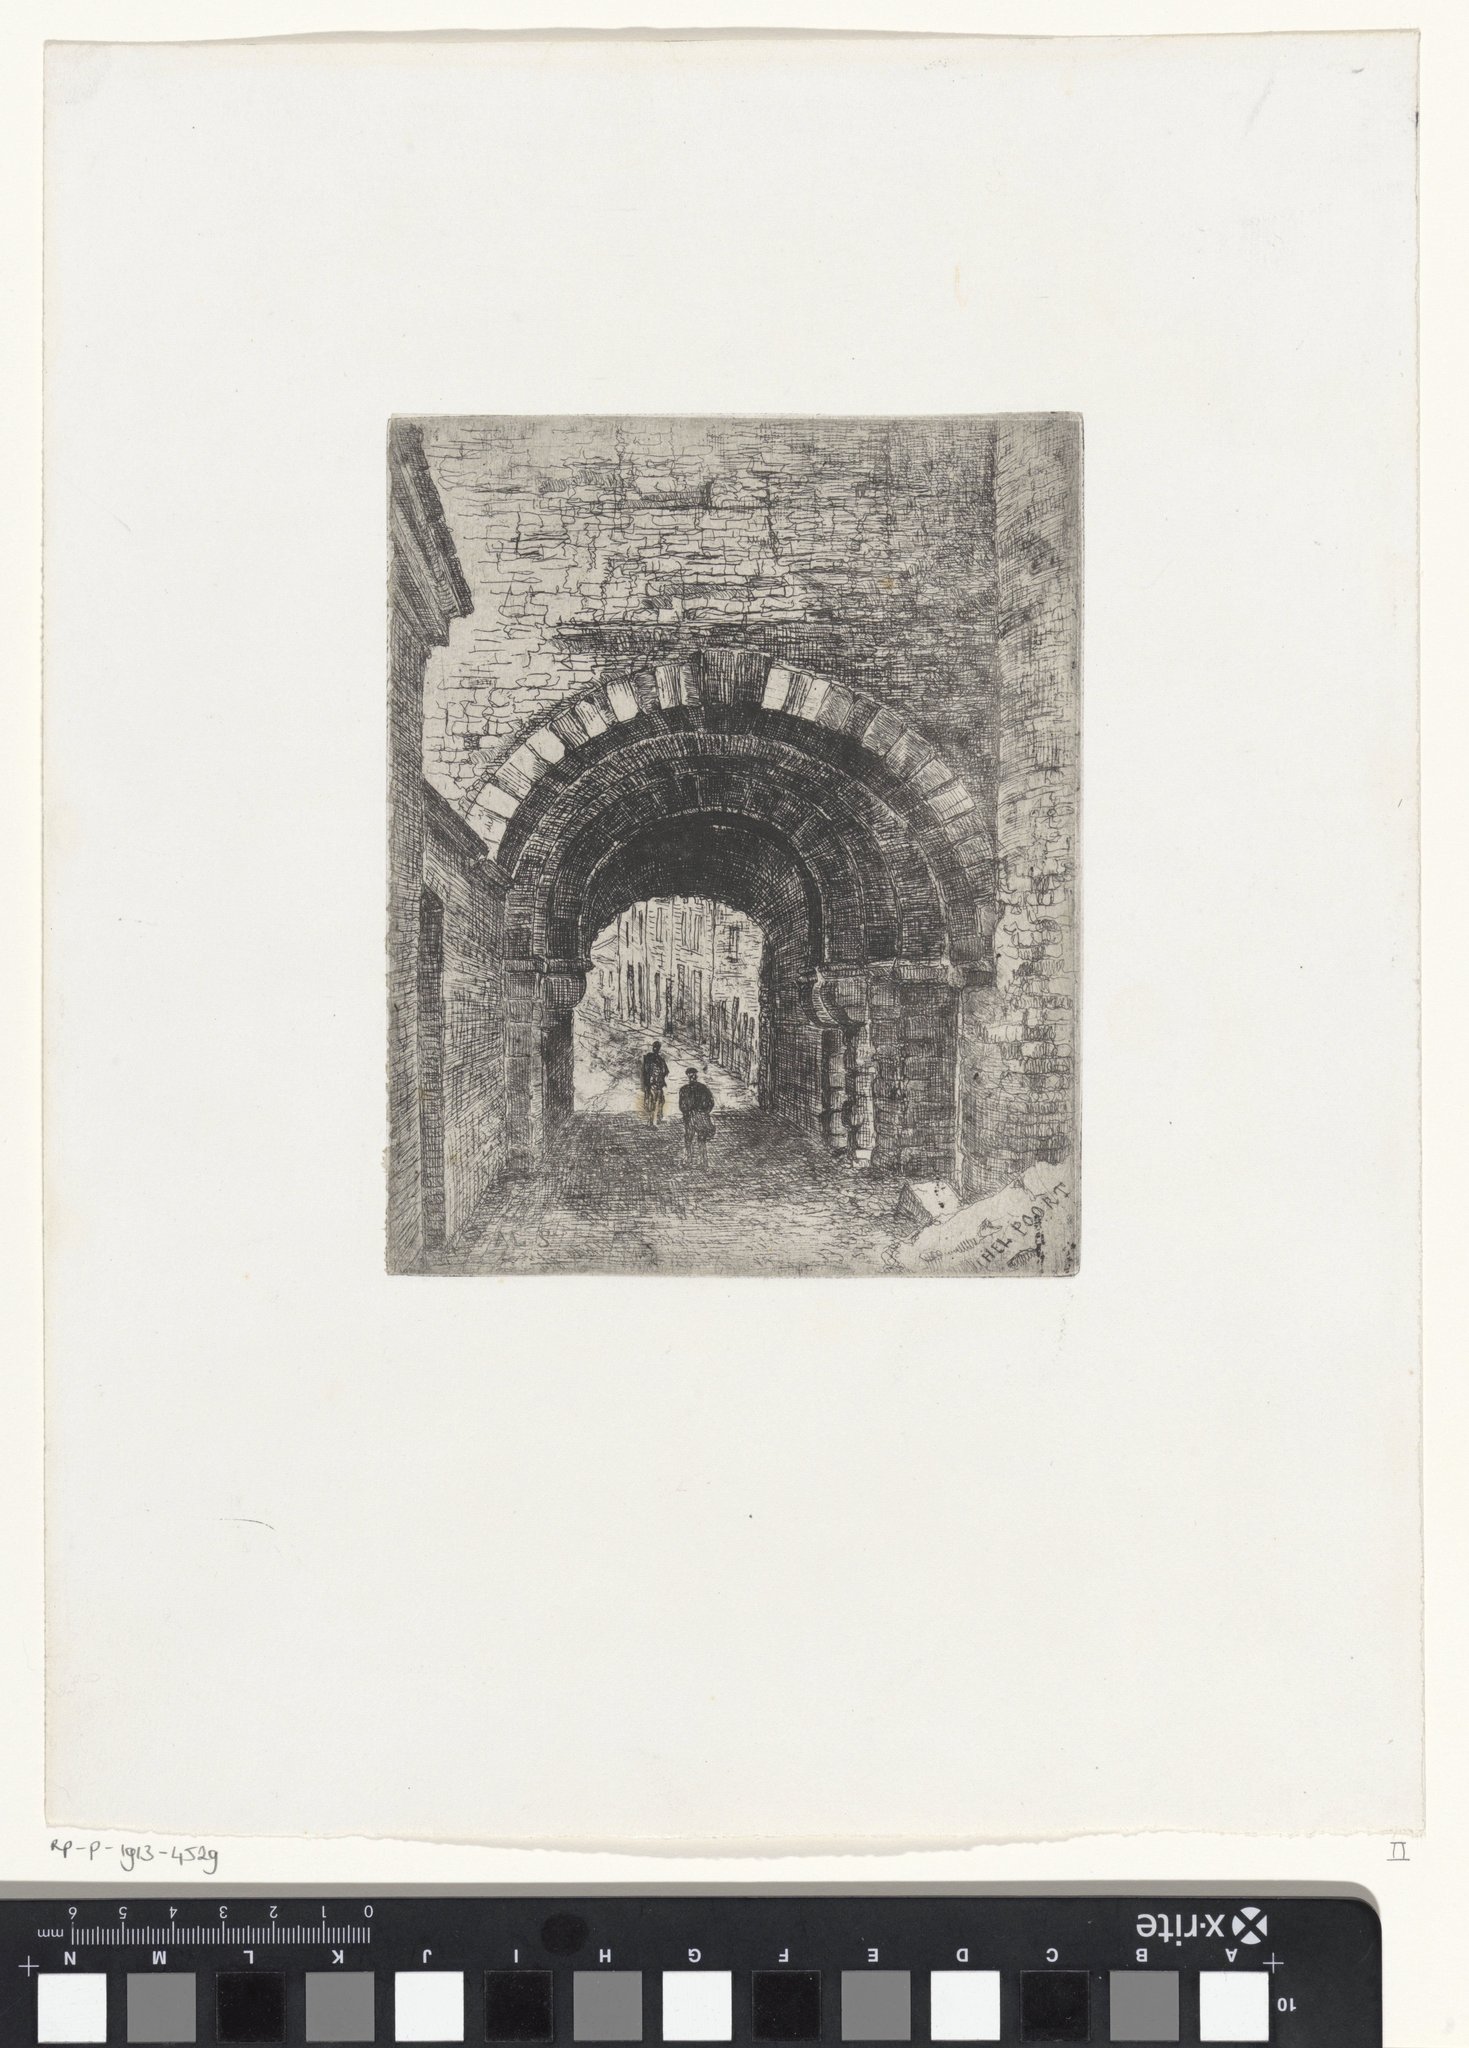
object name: print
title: Helpoort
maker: alexander schaepkens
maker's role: draughtsman, print maker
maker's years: 1815-1899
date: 1830-1899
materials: paper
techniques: etching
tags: city-gate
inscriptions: collector's mark: Lugt 2228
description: Helpoort, gezien vanaf de veldzijde, met zicht op de Sint Bernardusstraat.